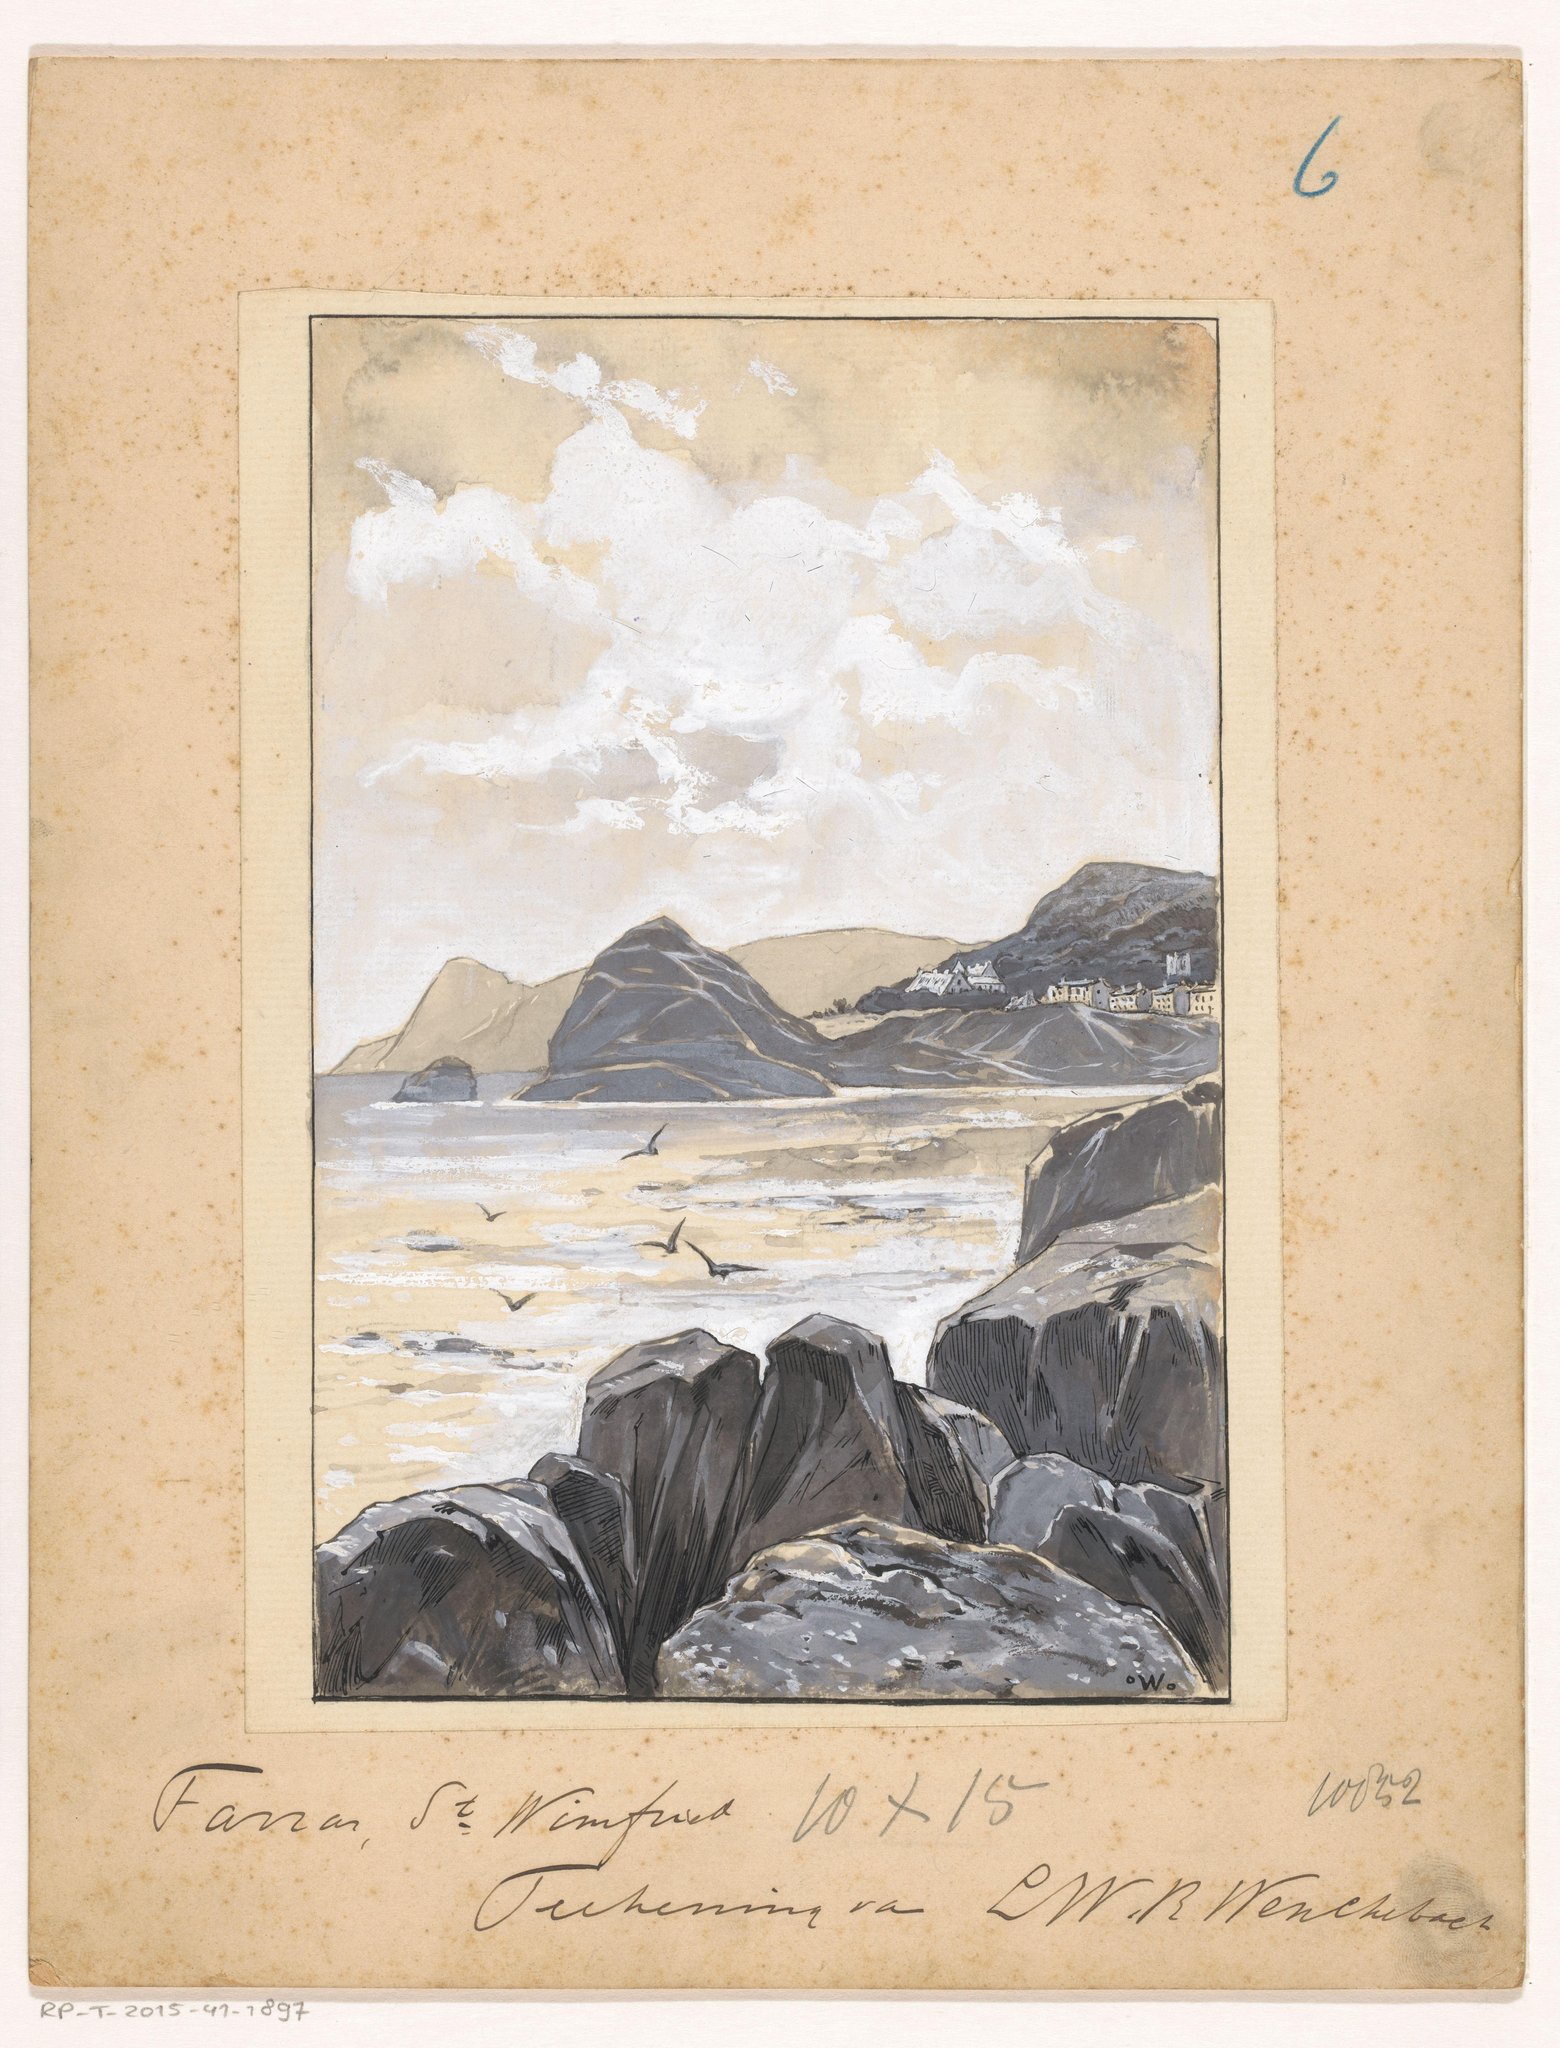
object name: drawing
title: Rotsachtige baai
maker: willem wenckebach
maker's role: designer, draughtsman, painter, print maker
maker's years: 1860-1937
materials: cardboard, paint, ink, paper, pencil, watercolor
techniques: brush, pen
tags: gulf, bay, city-view, and landscape with man-made constructions, rocky coast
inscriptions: annotation: ‘Farrar, St Wimfried Teekeningen van L.W.R. Wenckebach’, number: ‘6’, :, monogram: ‘.W.’, collector's mark: Lugt 2228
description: Gezicht op een rotsachtige baai met in de achtergrond huizen. Zeemeeuwen vliegen over het water.